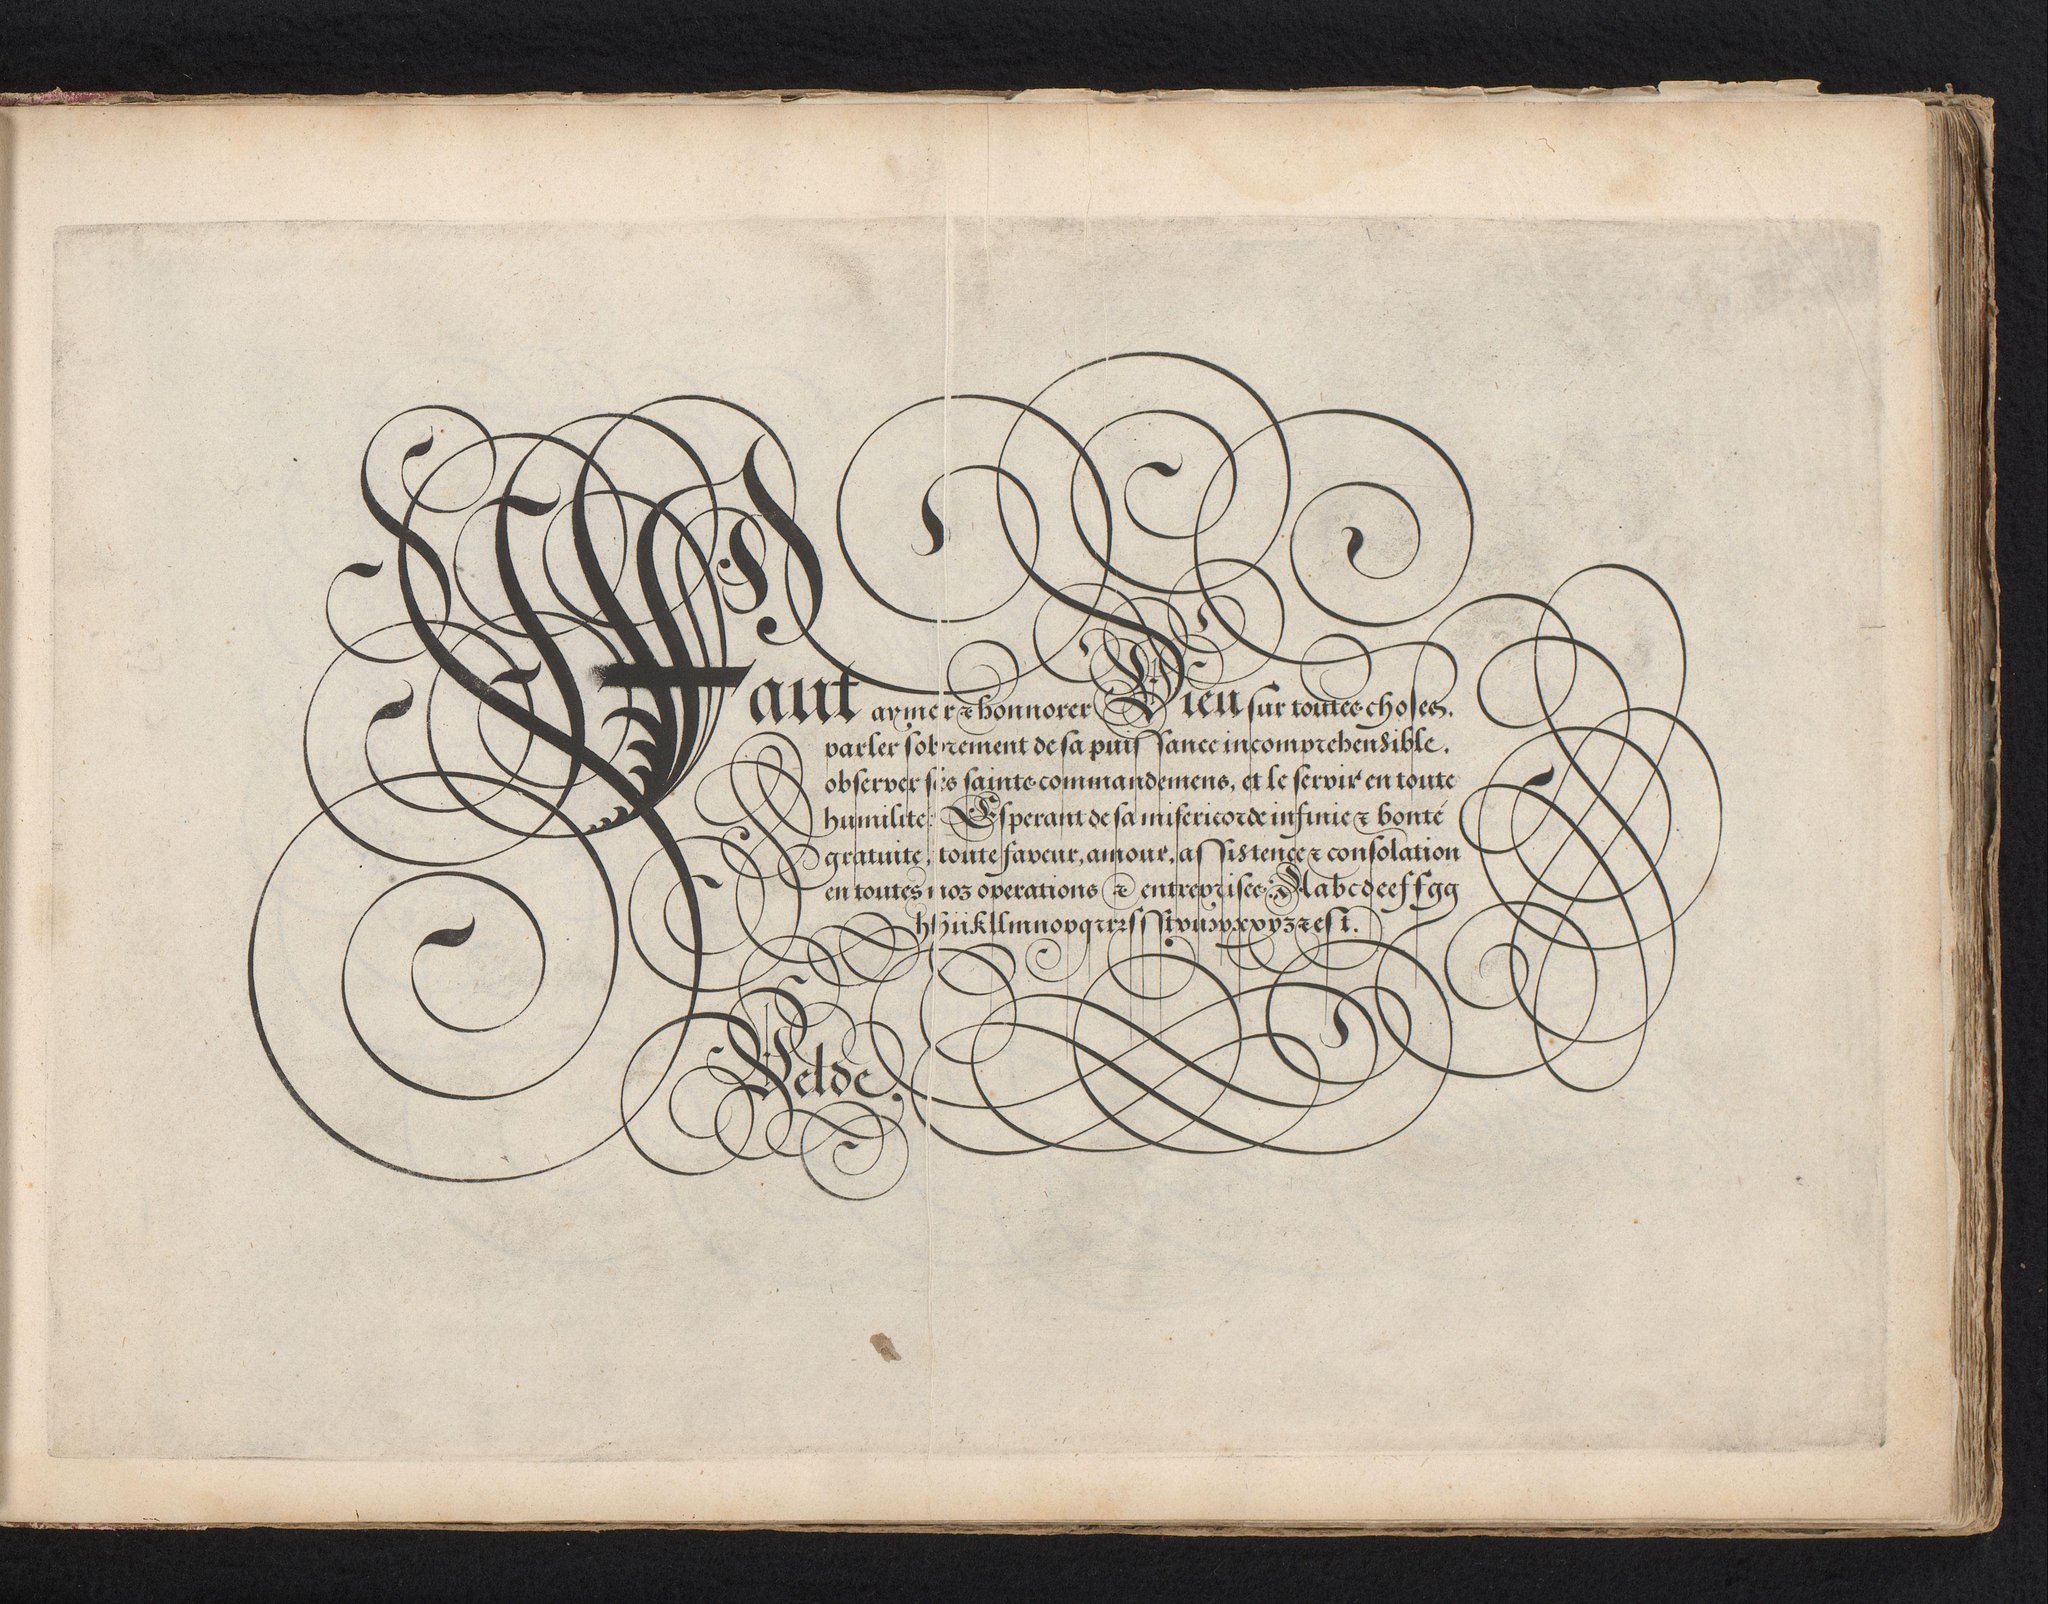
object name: print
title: Spieghel der schrijfkonste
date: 1605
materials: paper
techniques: engraving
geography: amsterdam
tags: calligraphy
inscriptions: collector's mark: Lugt 2760, collector's mark: Lugt 2228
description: Schrijfvoorbeeld met geornamenteerde initiaal F en zeven regels tekst: Faut aymer ... Onderaan een onderkastalfabet in de betreffende hand. De tekst is omlijst door krulwerk. De prent maakt deel uit van een album.